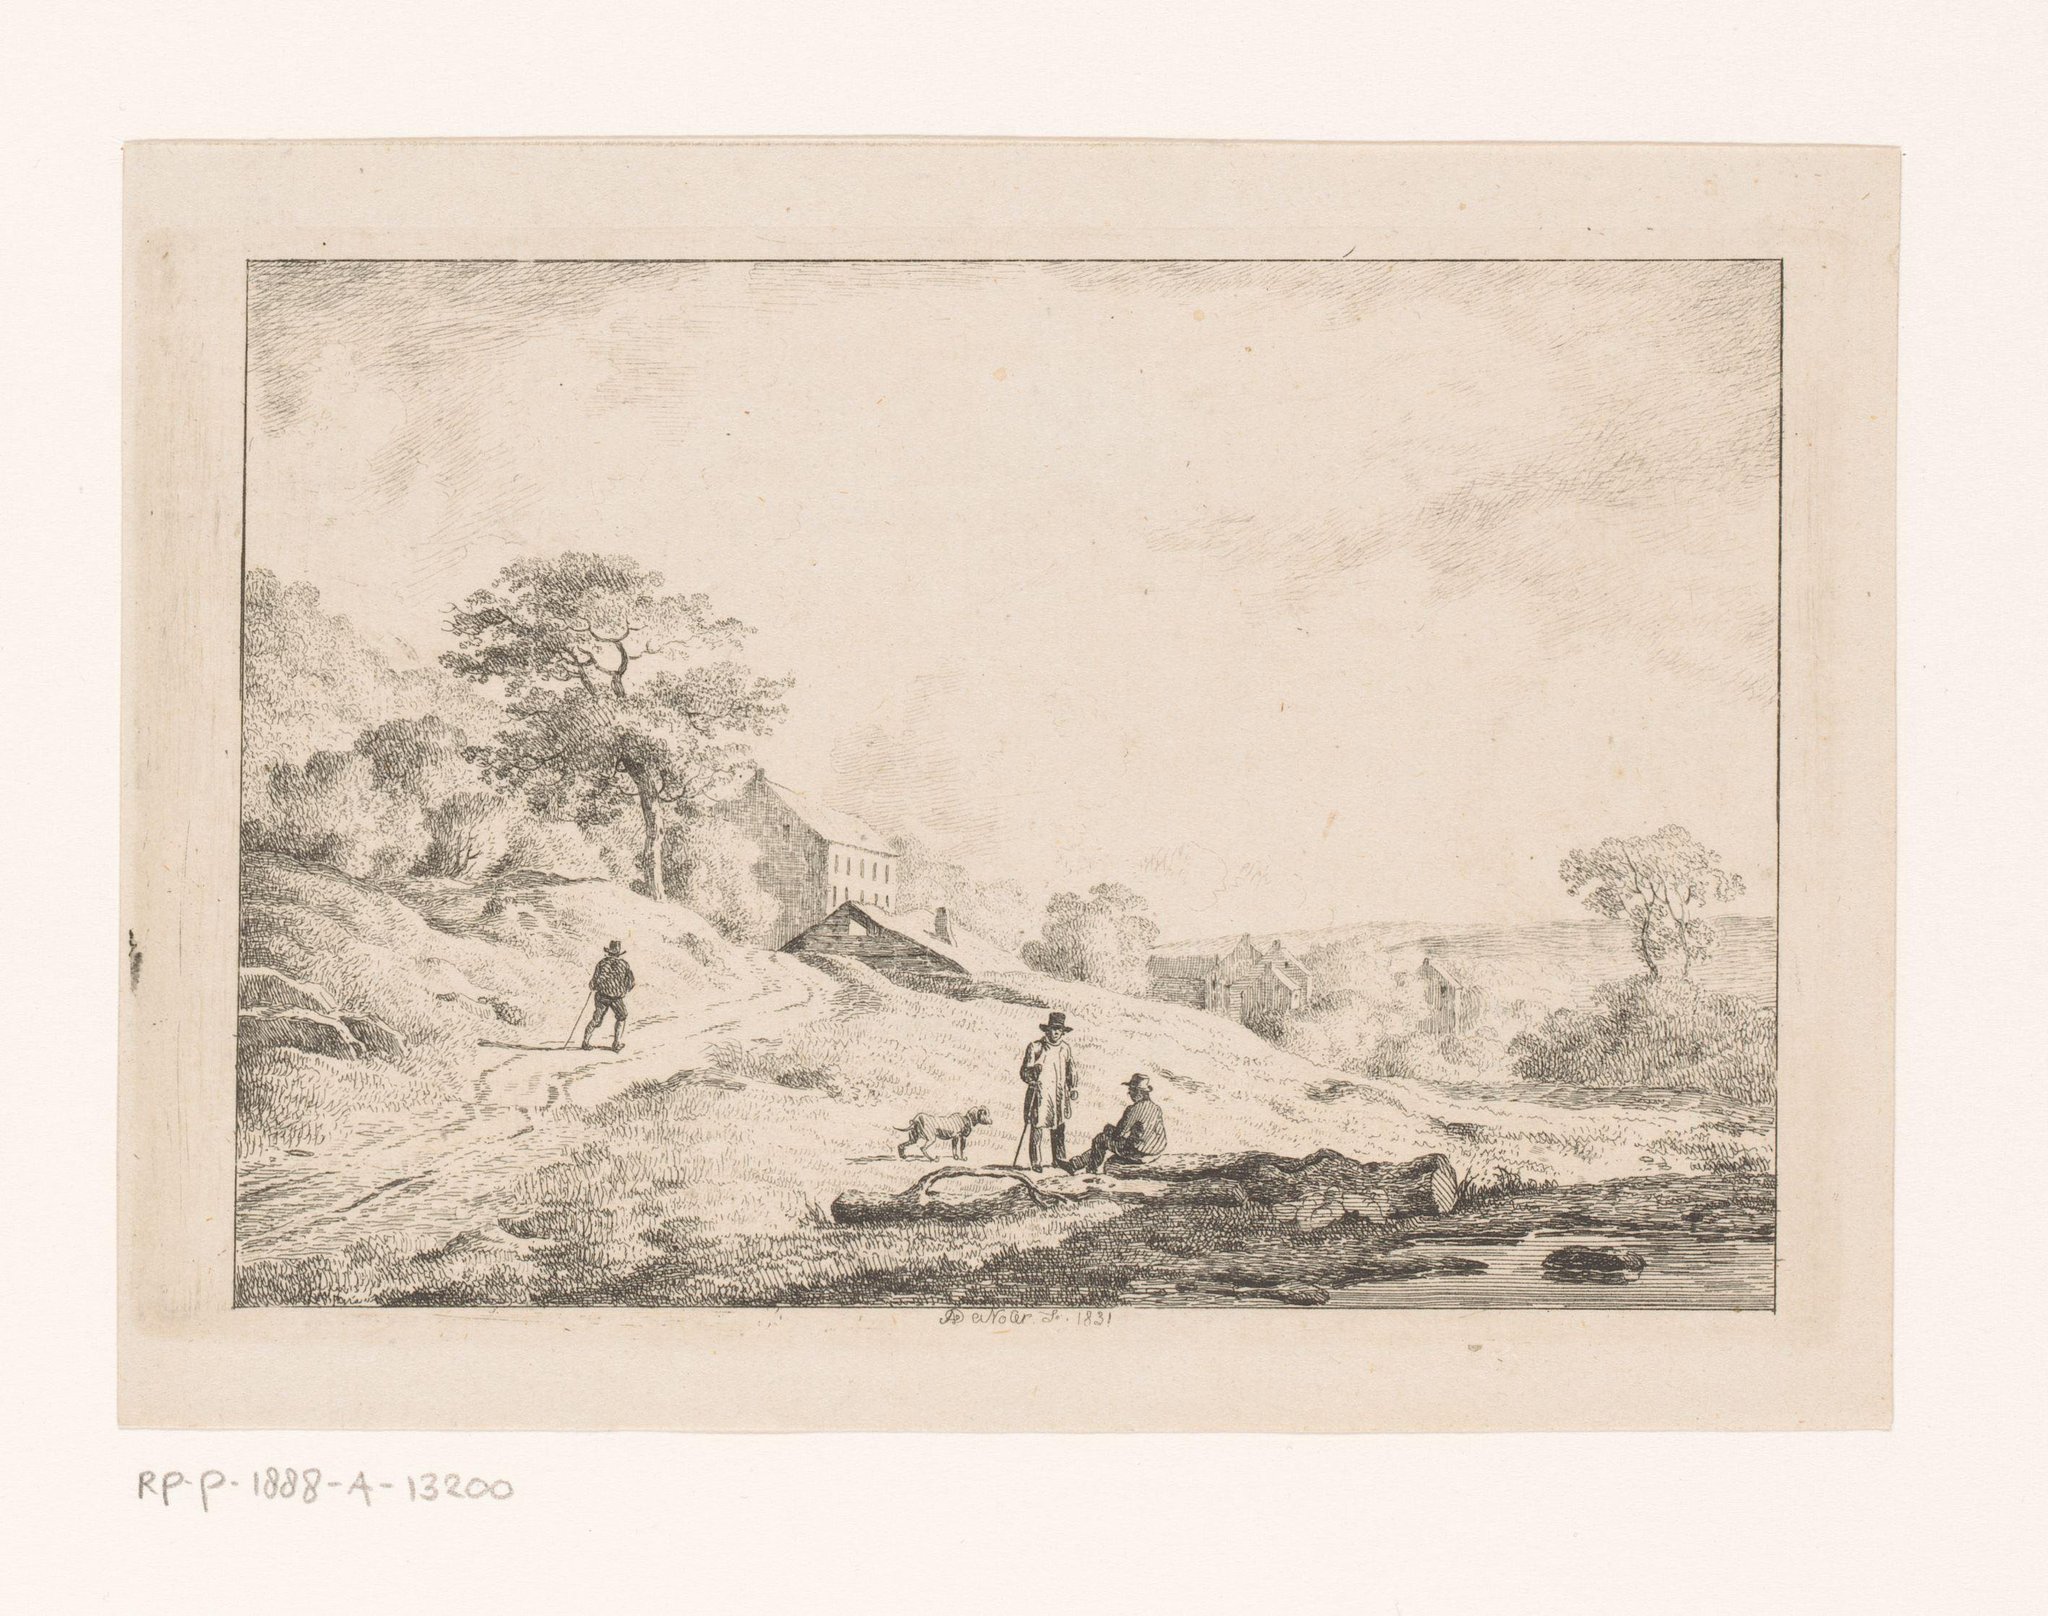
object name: print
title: Heuvellandschap met figuren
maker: auguste herman marie de noter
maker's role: print maker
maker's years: 1806-1838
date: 1831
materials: paper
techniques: etching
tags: low hill country (+ landscape with figures, staffage), dog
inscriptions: collector's mark: Lugt 2228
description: Twee figuren op de voorgrond zijn met elkaar in gesprek.